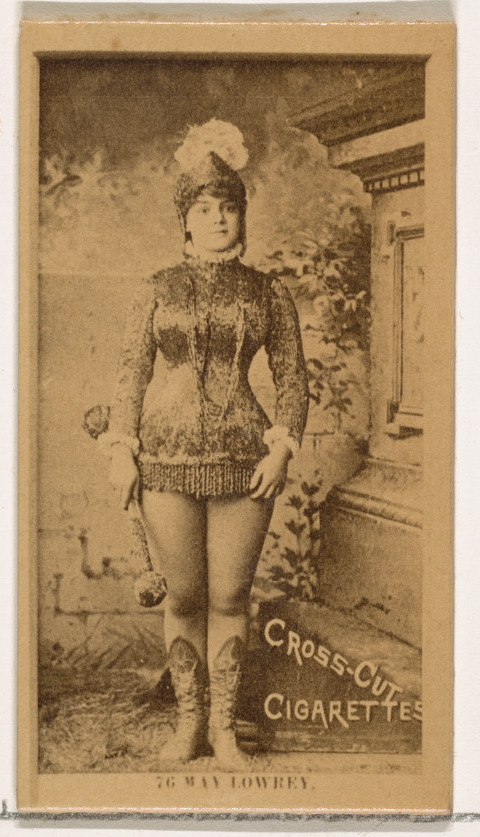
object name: print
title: Card Number 76, May Lowrey, from the Actors and Actresses series (N145-2) issued by Duke Sons & Co. to promote Cross Cut Cigarettes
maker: w. duke, sons & co.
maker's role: publisher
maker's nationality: american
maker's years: 1870-1920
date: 1880-1889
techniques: albumen silver print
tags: portraits,women,actresses